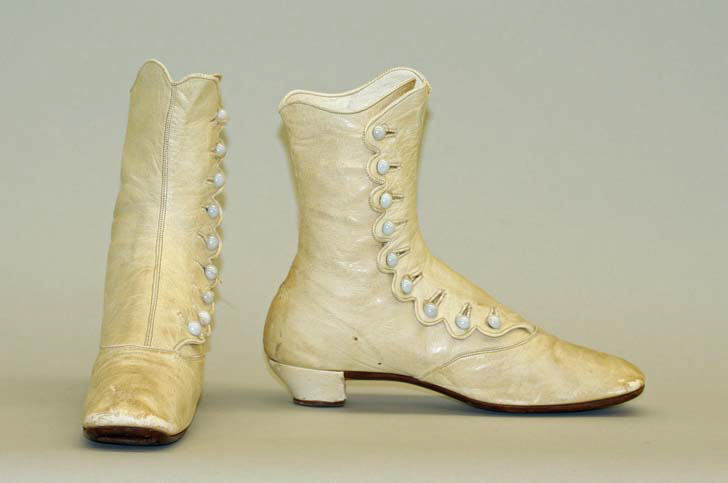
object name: boot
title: Boots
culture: american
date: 1870-1879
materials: leather